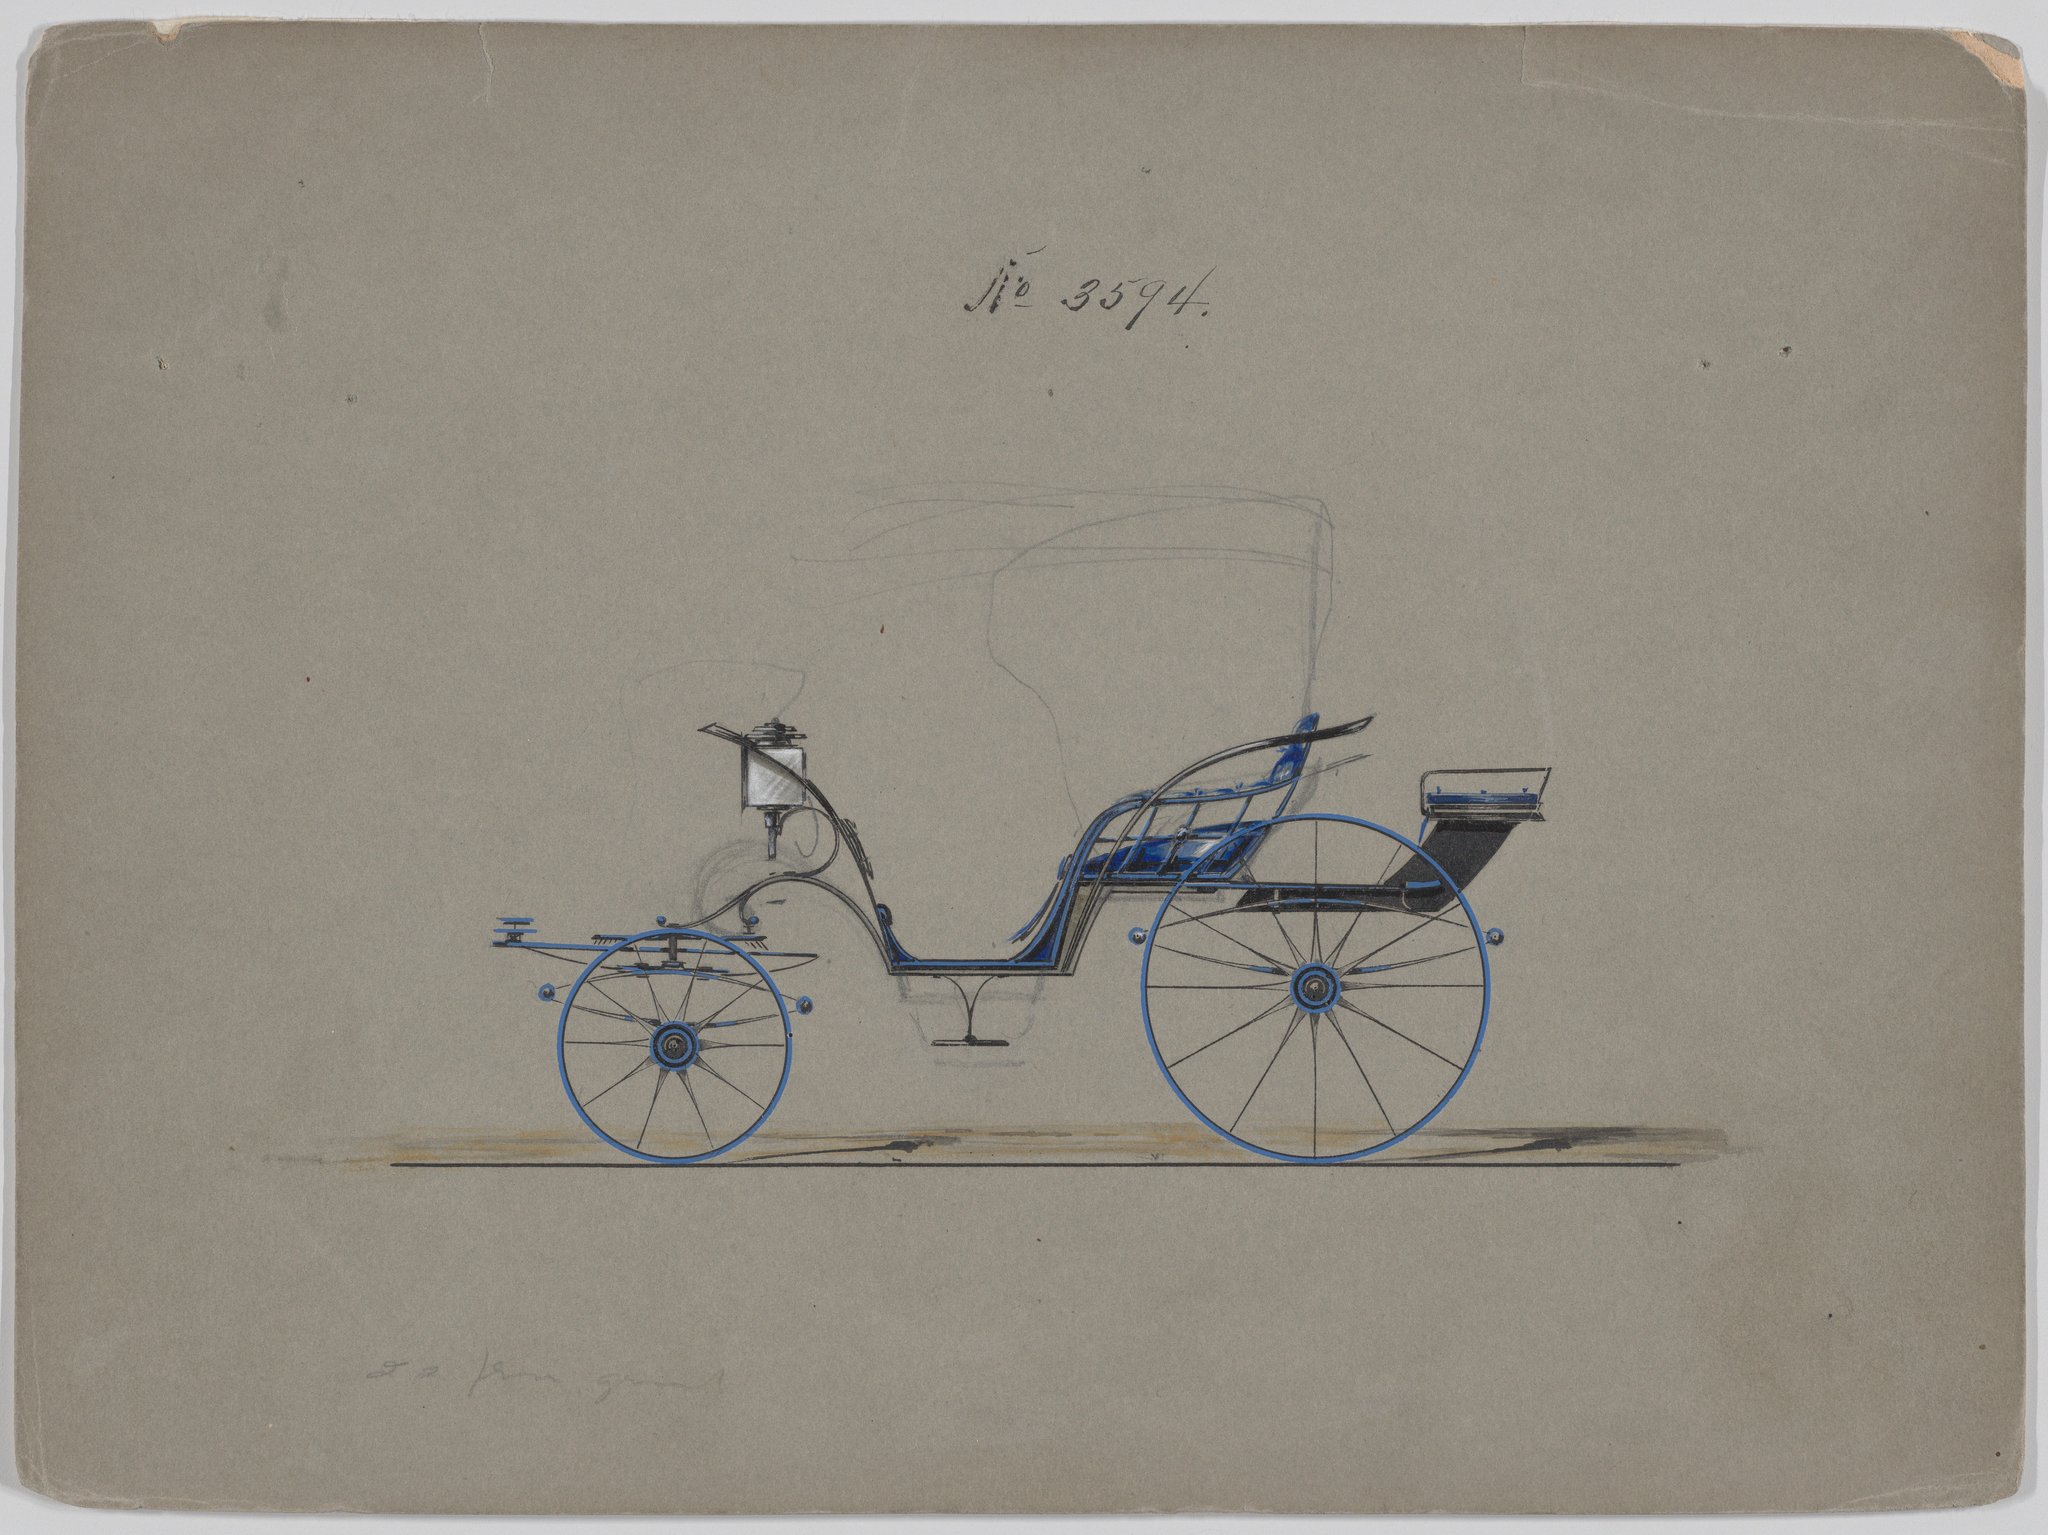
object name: drawing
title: Design for Pony Phaeton, no. 3594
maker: brewster & co.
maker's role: manufacturer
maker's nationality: american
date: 1880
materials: gouache, gum arabic, ink, watercolor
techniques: pen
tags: carriages